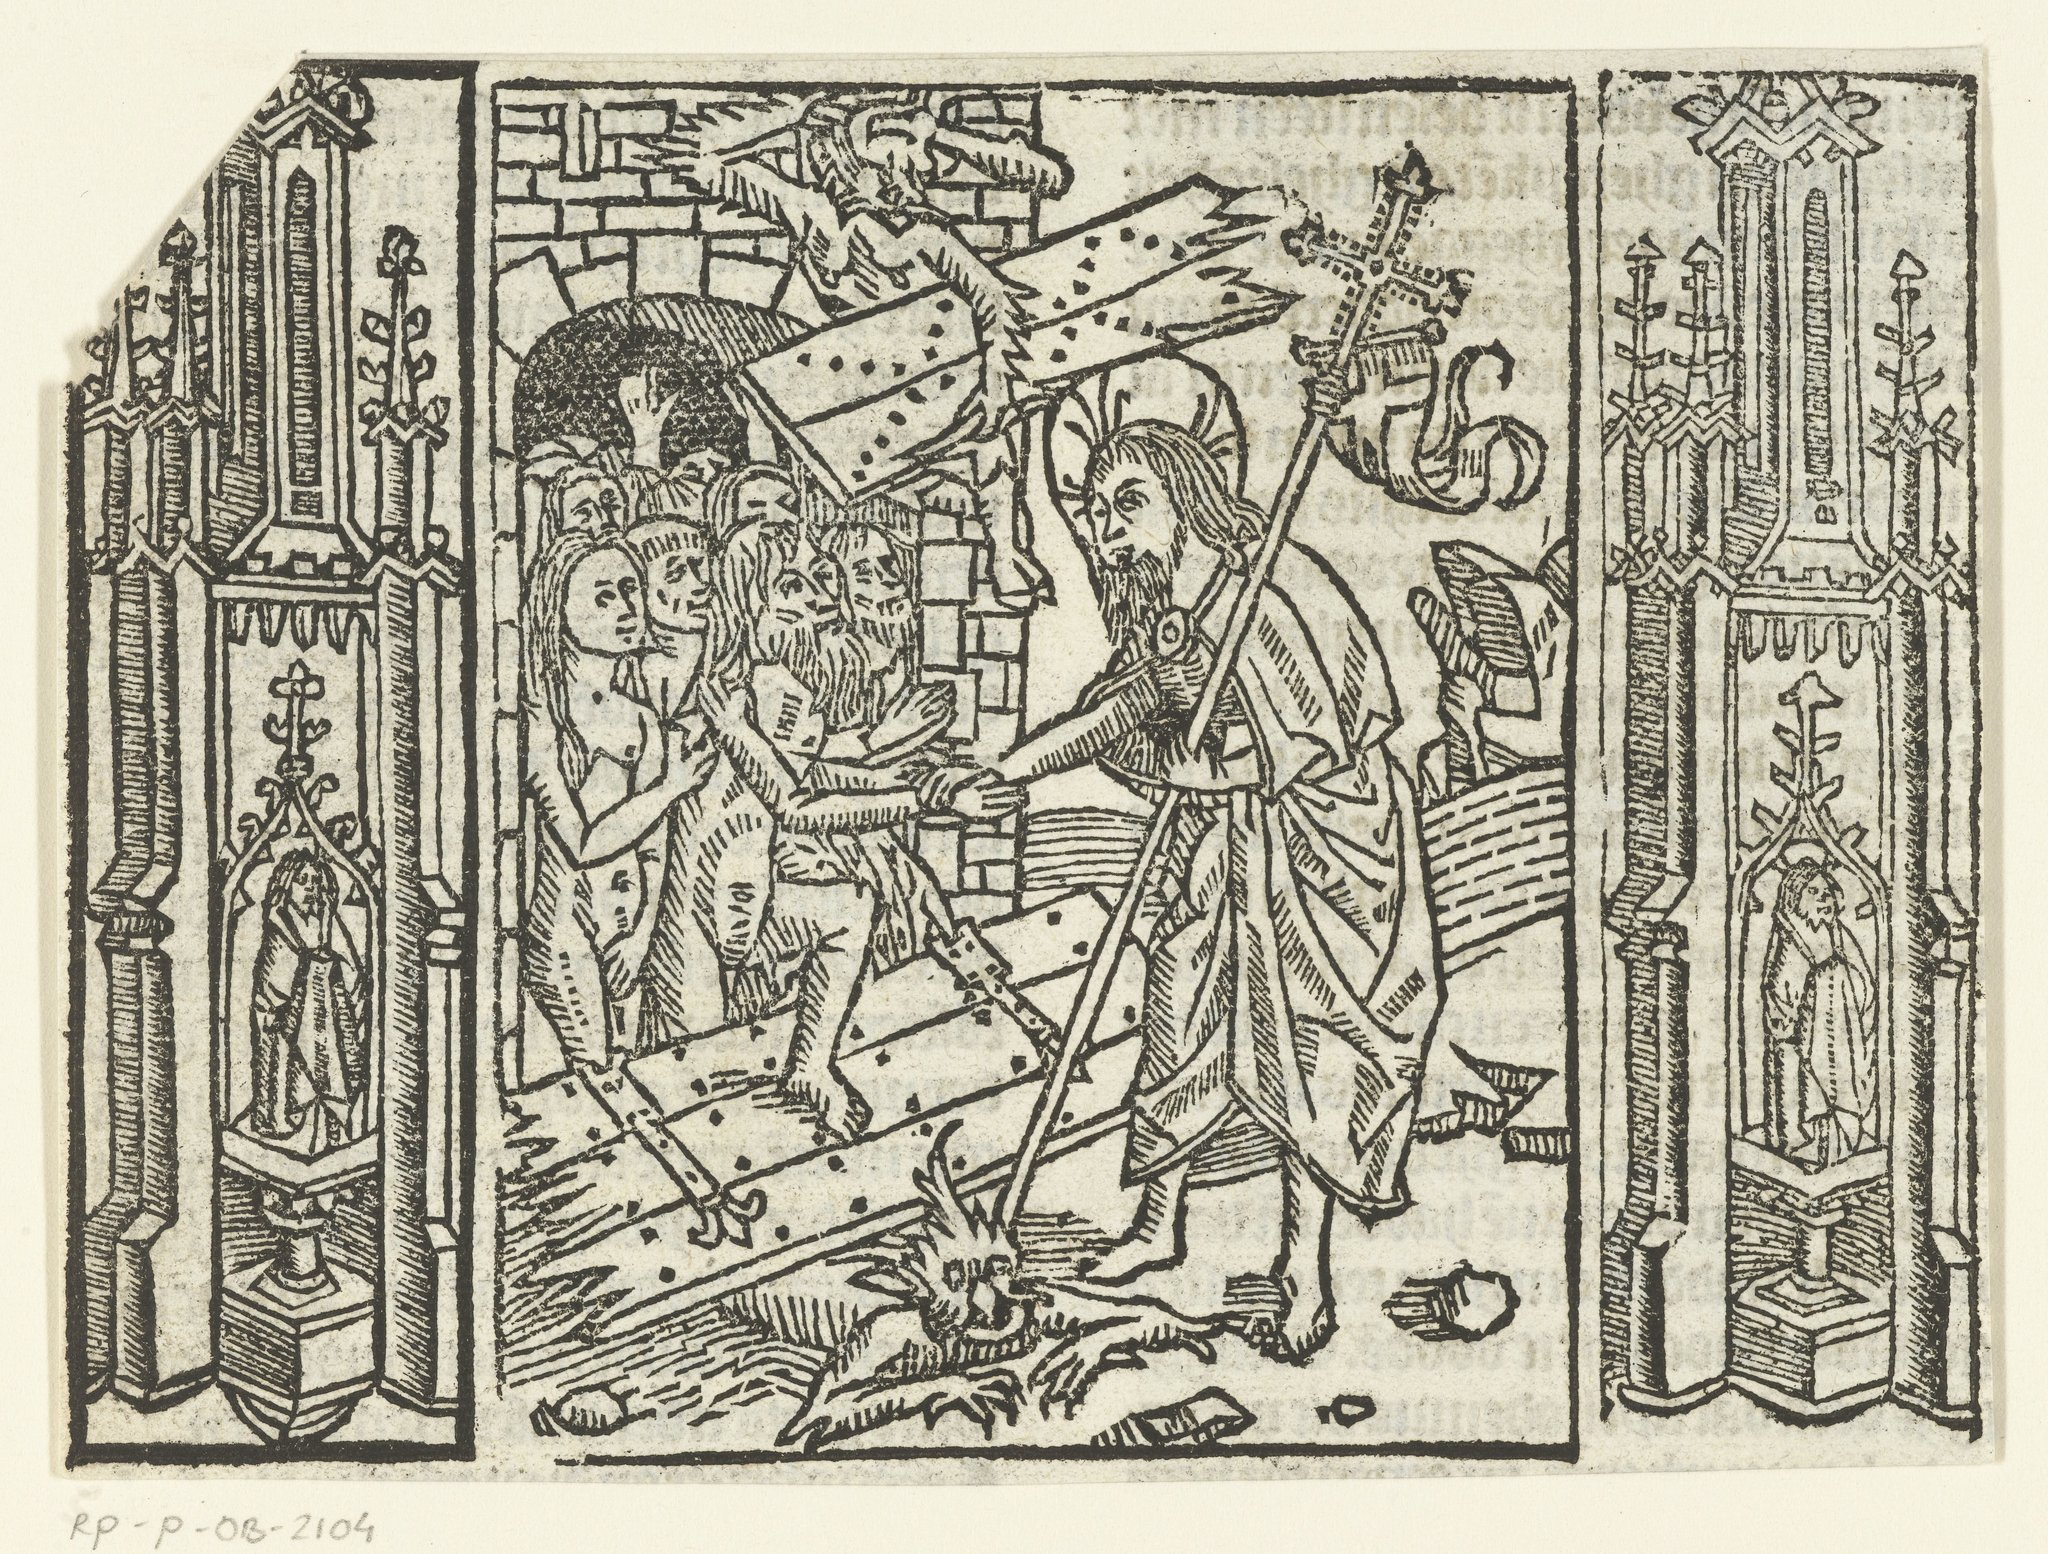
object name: print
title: Anastasis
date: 1480-1500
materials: paper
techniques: woodcut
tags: christ arrives at the entrance of hell and breaks the door(s)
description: Eén blad van 113 uit Ludolphus de Saxonia, "Dit es dleué ons liefs heeren ihesu christi". Anonieme Nederlandse vertaling. Uitgegeven door Henrick Eckert van Homberch te Antwerpen in 1503. Botke, K. Deze 113 houtsneden, die meestal reeds in vroege Nederlandse boeken gebruikt zijn, worden toegeschreven aan de tweede Meester van Delft, de Meester van de Delbecq-Schreiber-passie en de Meester van de Virgo inter Virgines. In Conway (1884) en in "De gulden passer"(1951) zijn ook eerdere versies opgenomen. Botke, K.